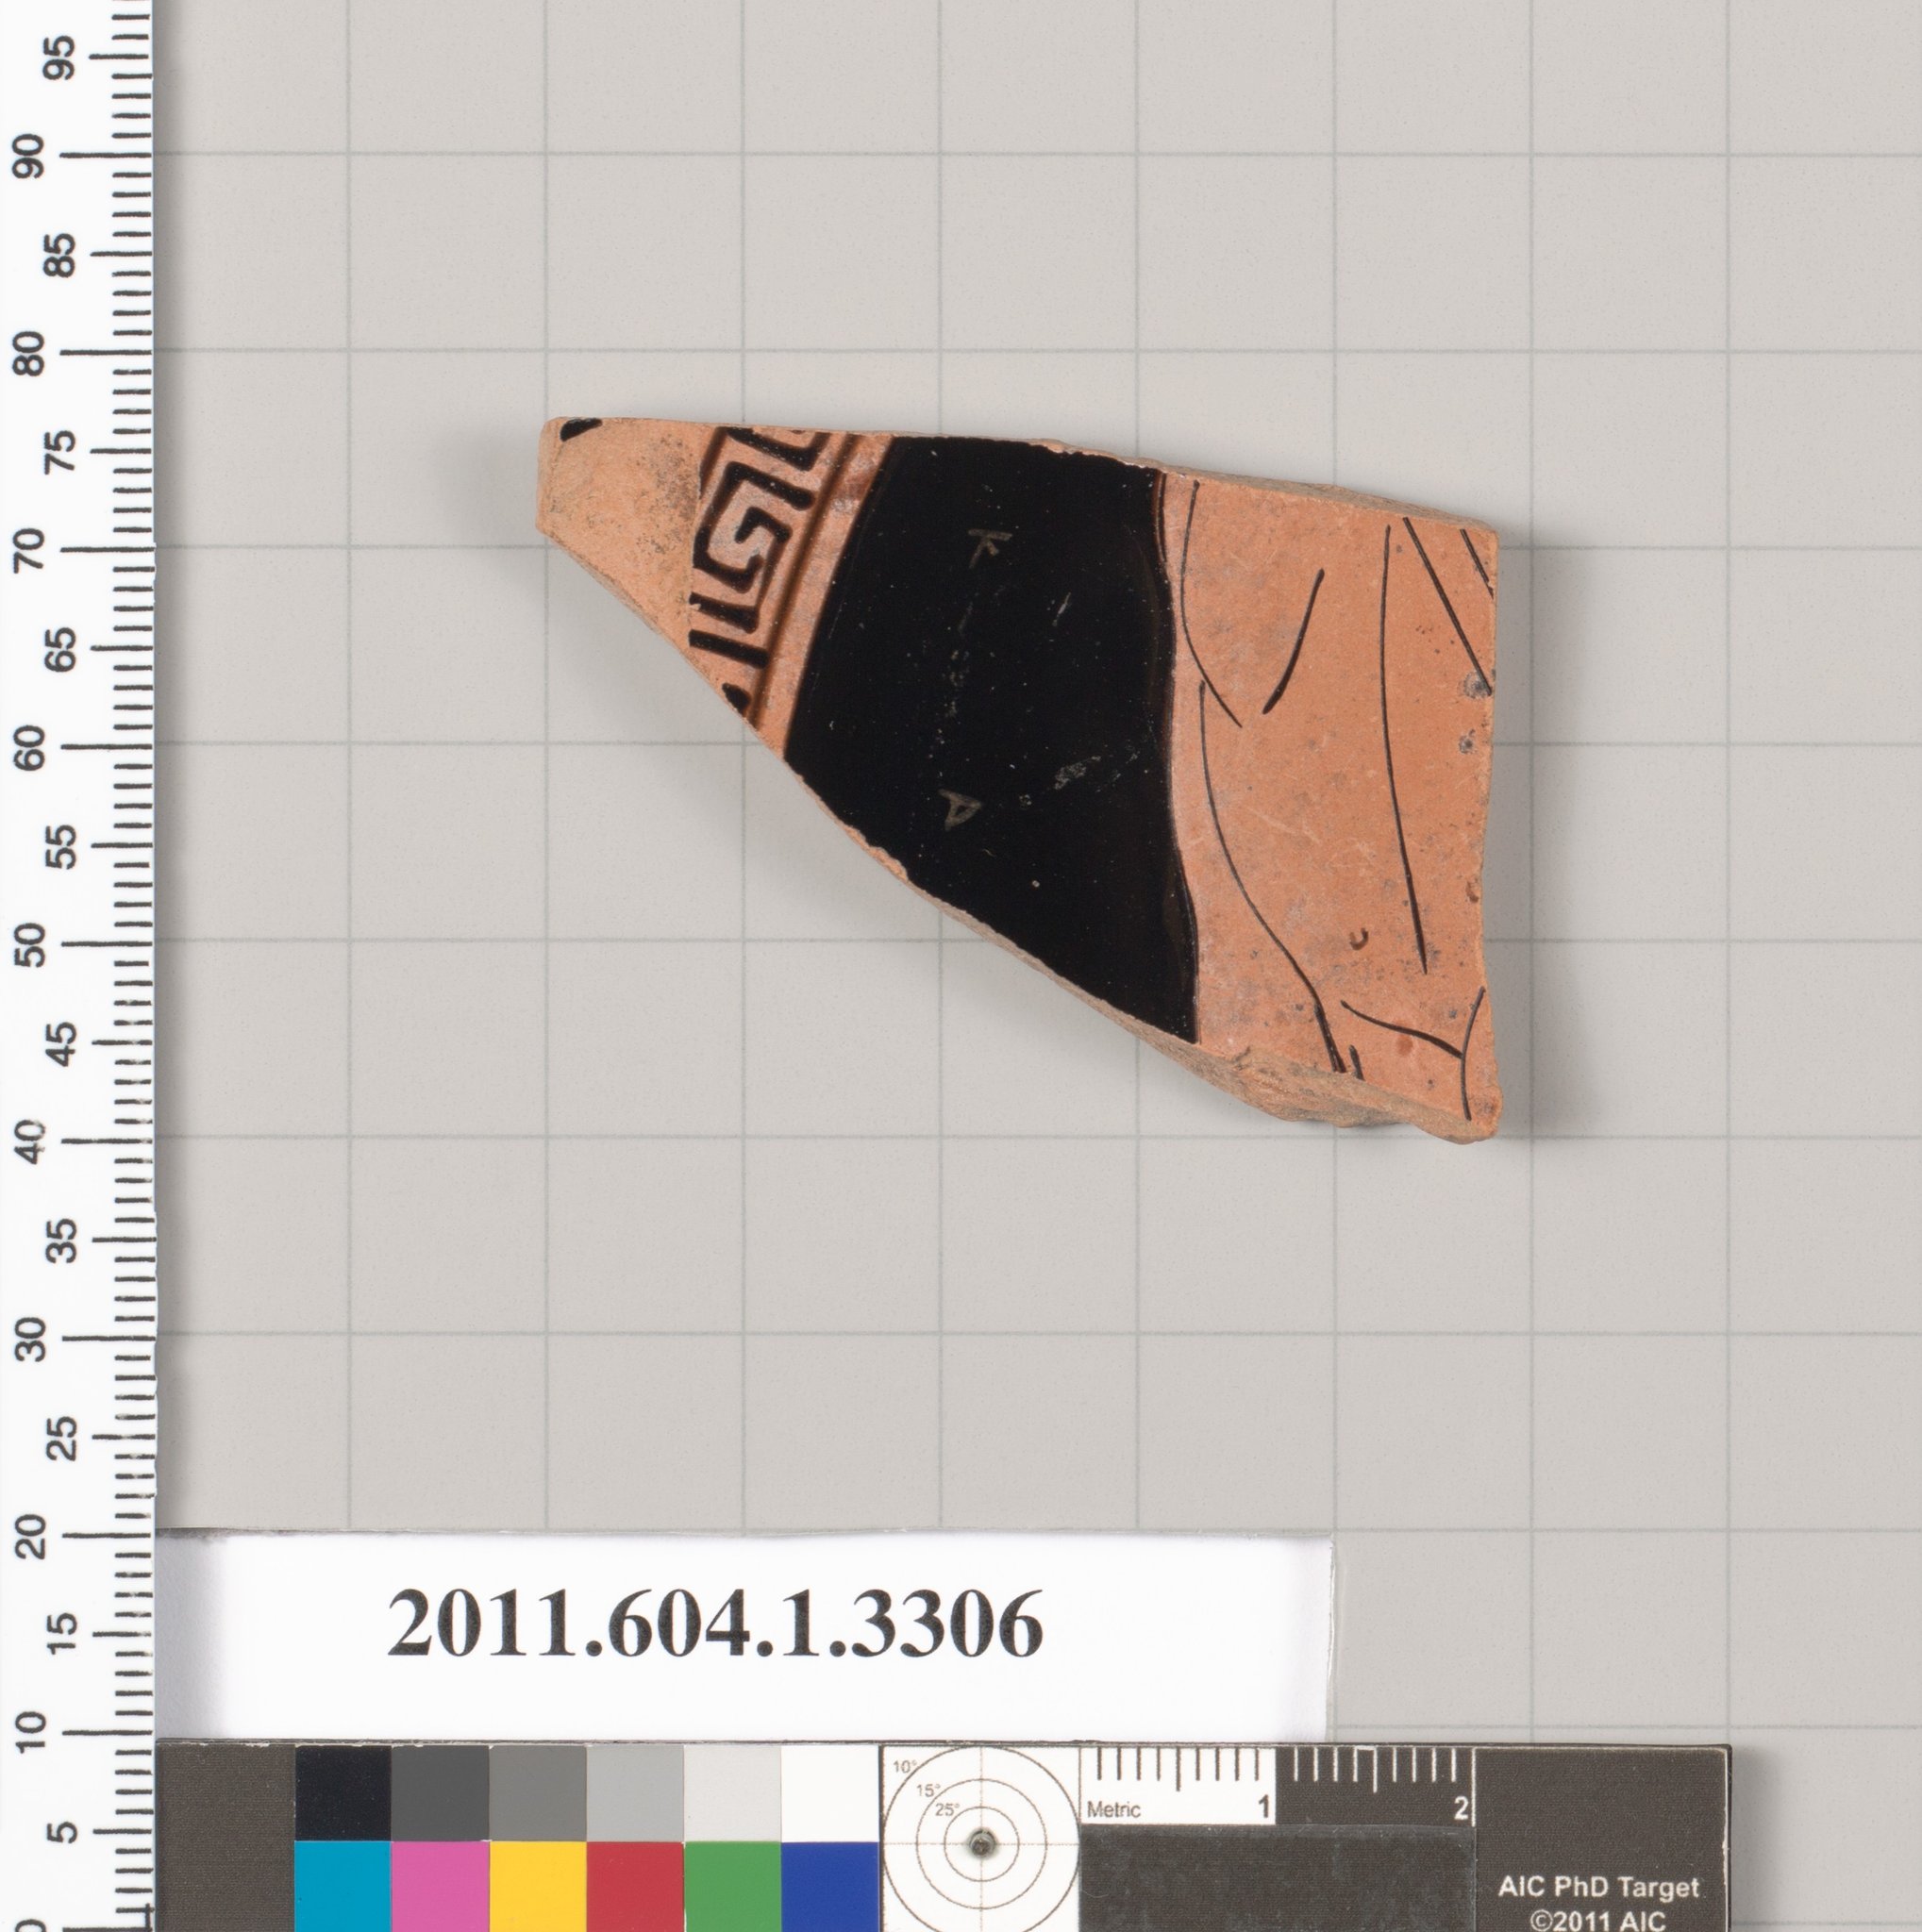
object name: kylix fragment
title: Terracotta fragment of a kylix (drinking cup)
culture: greek, attic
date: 475-451 BCE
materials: terracotta